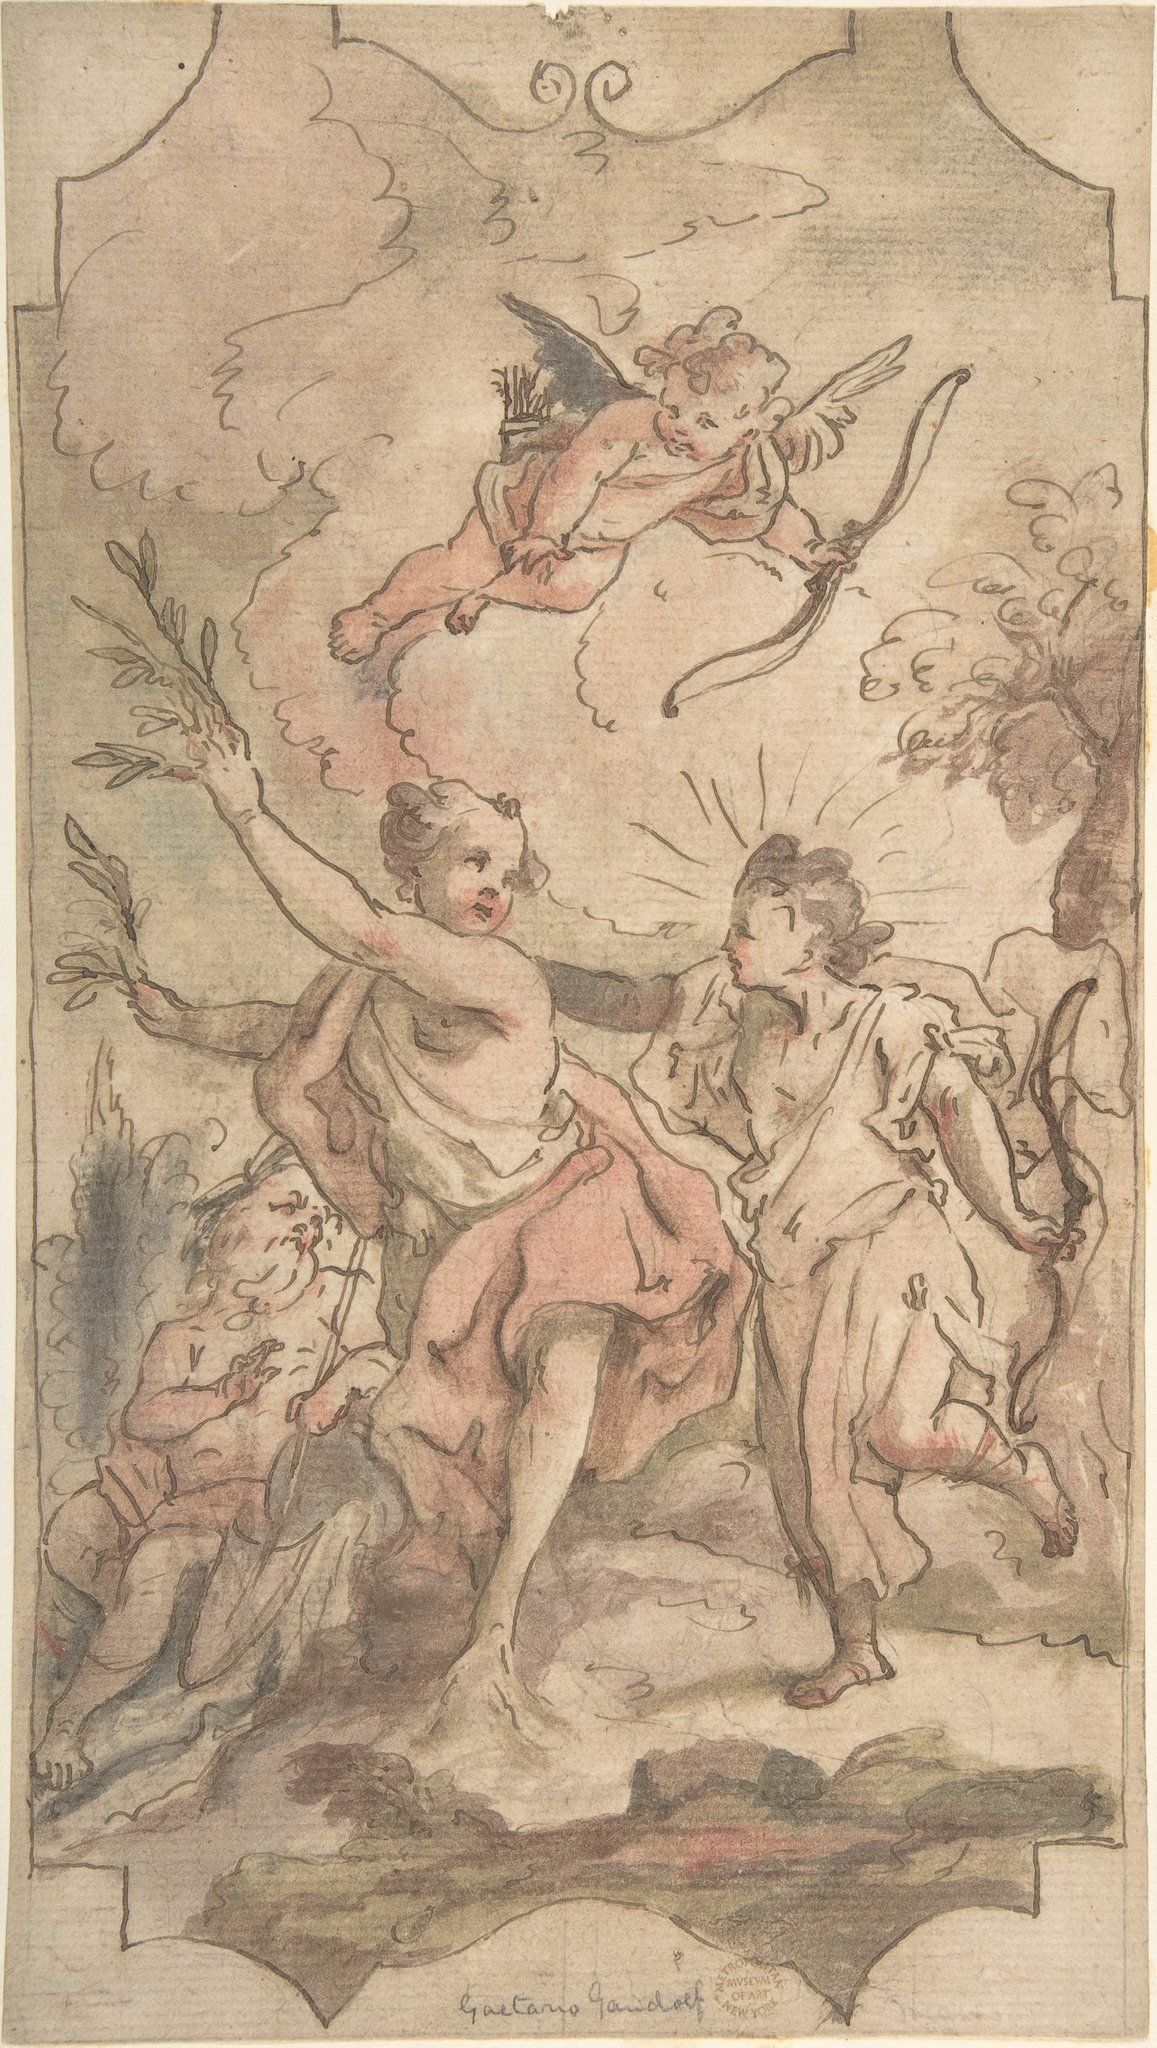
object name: drawing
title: Apollo and Daphne: Design for a Wall or Ceiling Panel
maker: anonymous, italian, 18th century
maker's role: artist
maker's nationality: italian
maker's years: 1700-1800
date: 1701-1800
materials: ink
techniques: pen, wash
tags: cupid,apollo